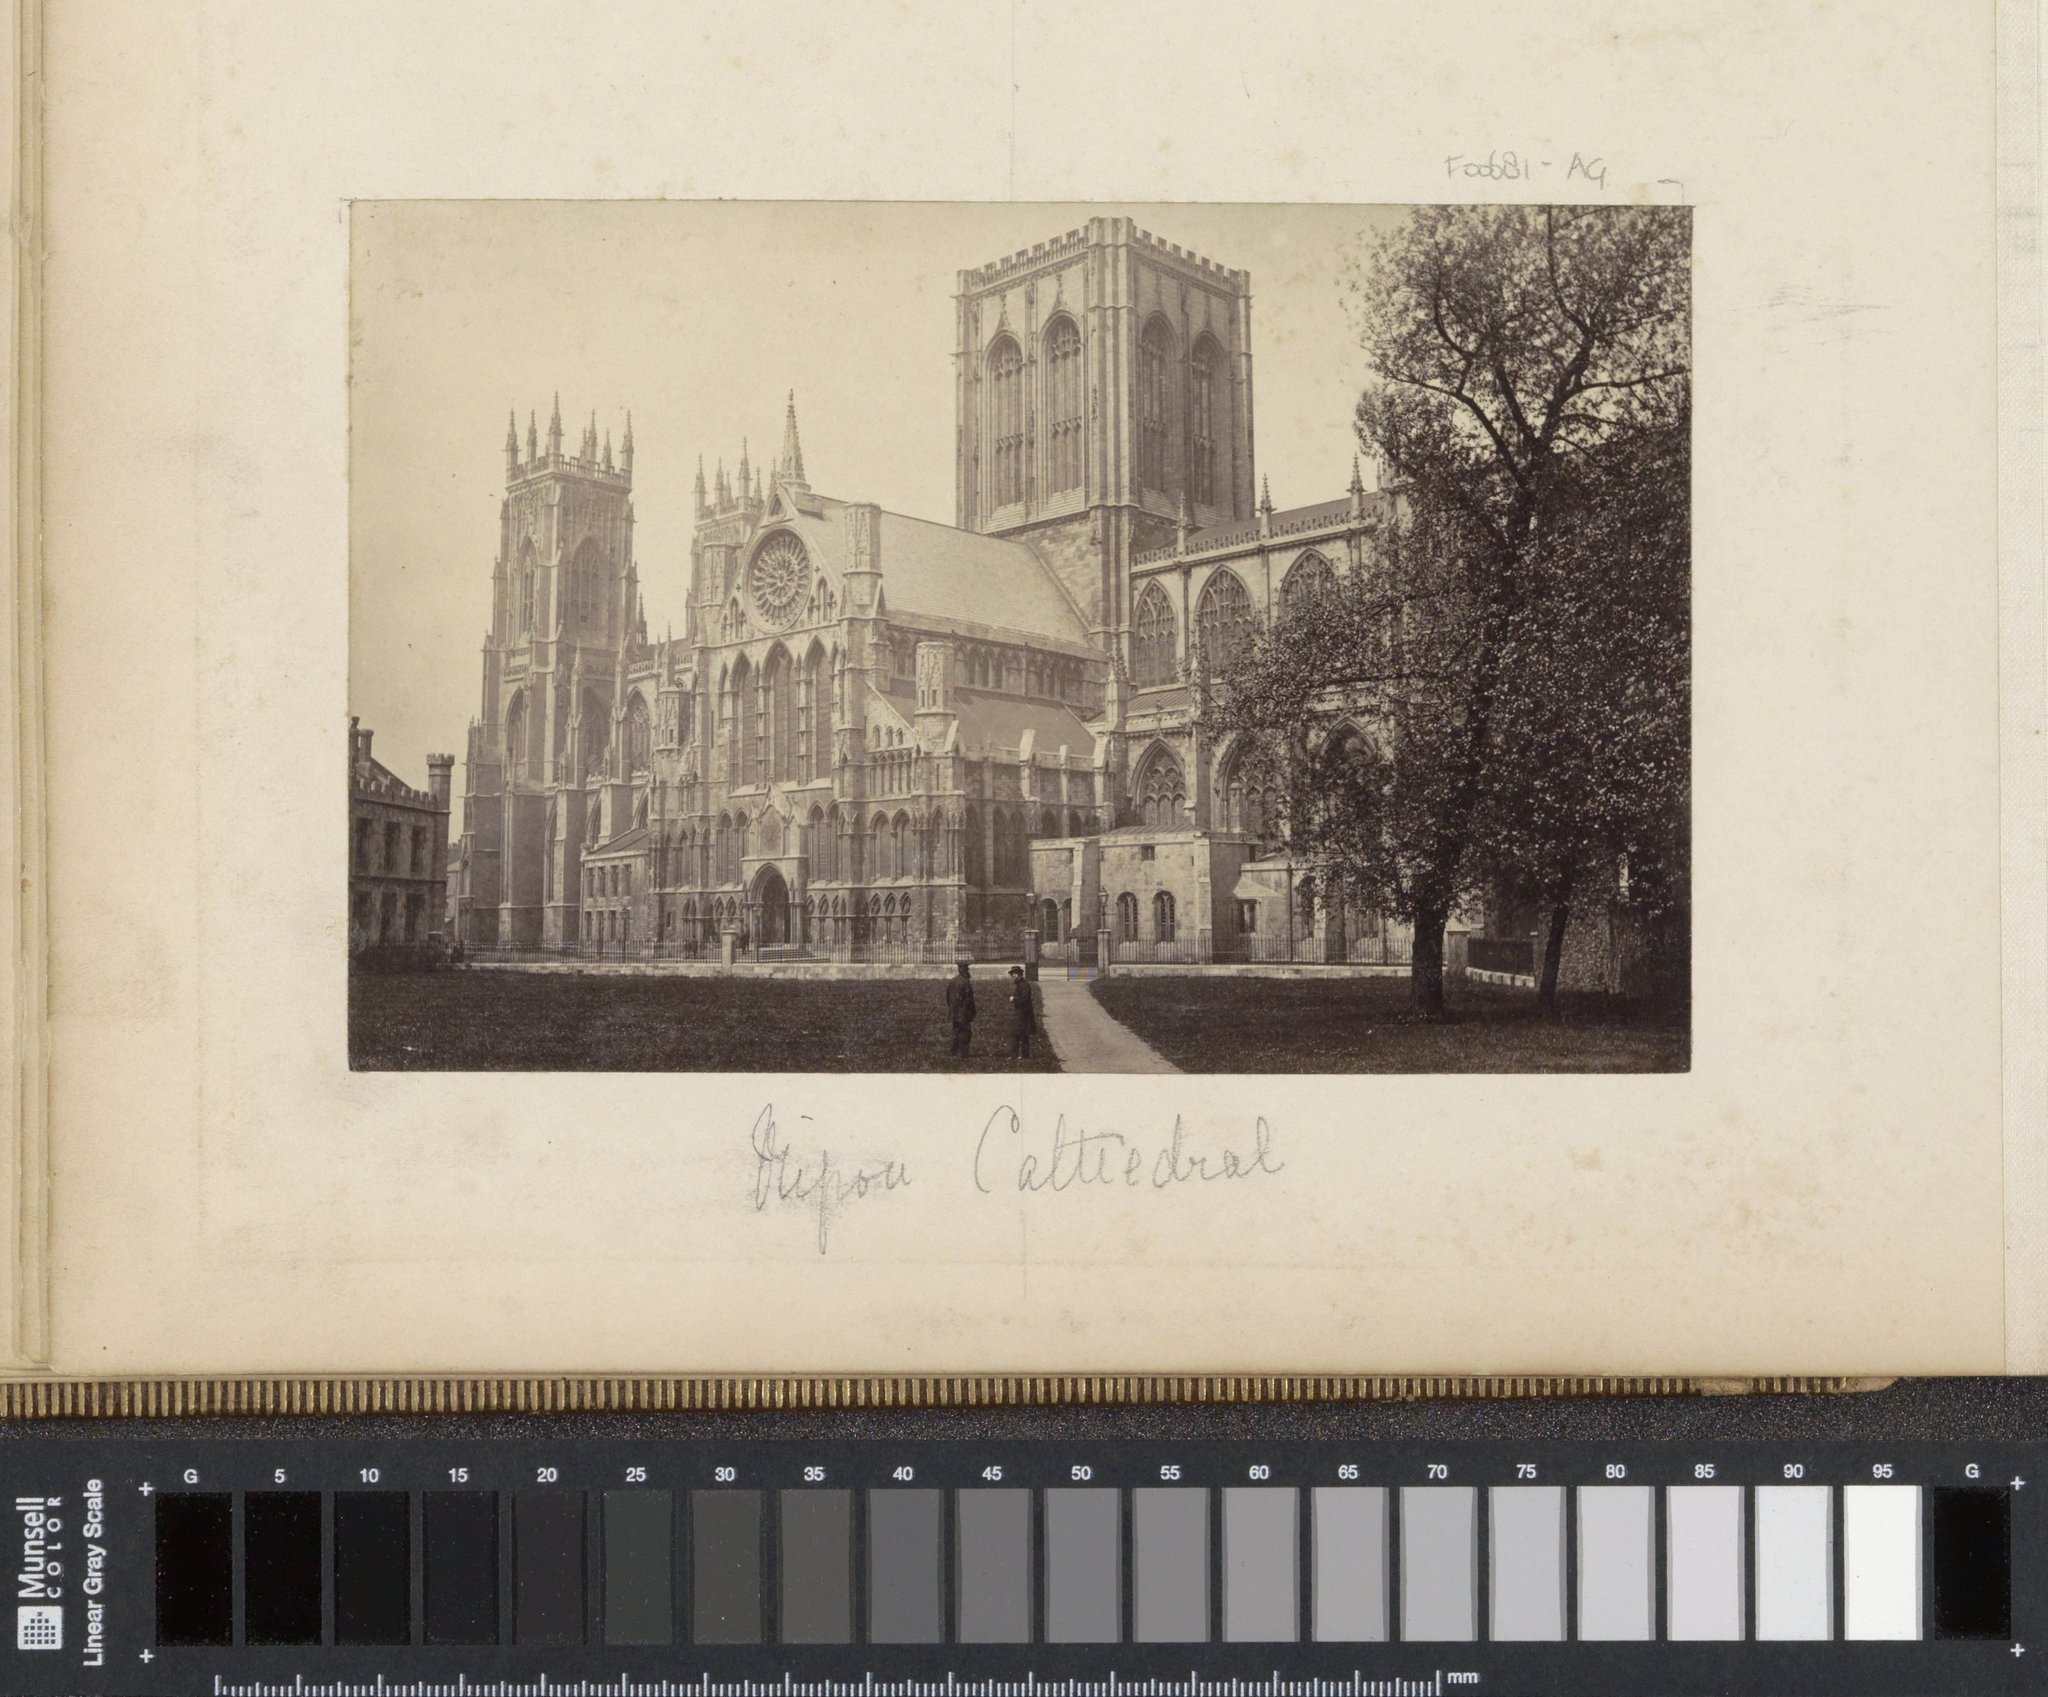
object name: photograph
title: Kathedraal in Engeland met op de voorgrond twee mannen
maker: Anonymous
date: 1850-1870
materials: paper, photographic support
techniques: albumen print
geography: england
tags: church (exterior), england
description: Onderdeel van Album met foto's van bezienswaardigheden en landschappen in Engeland en van kunst.